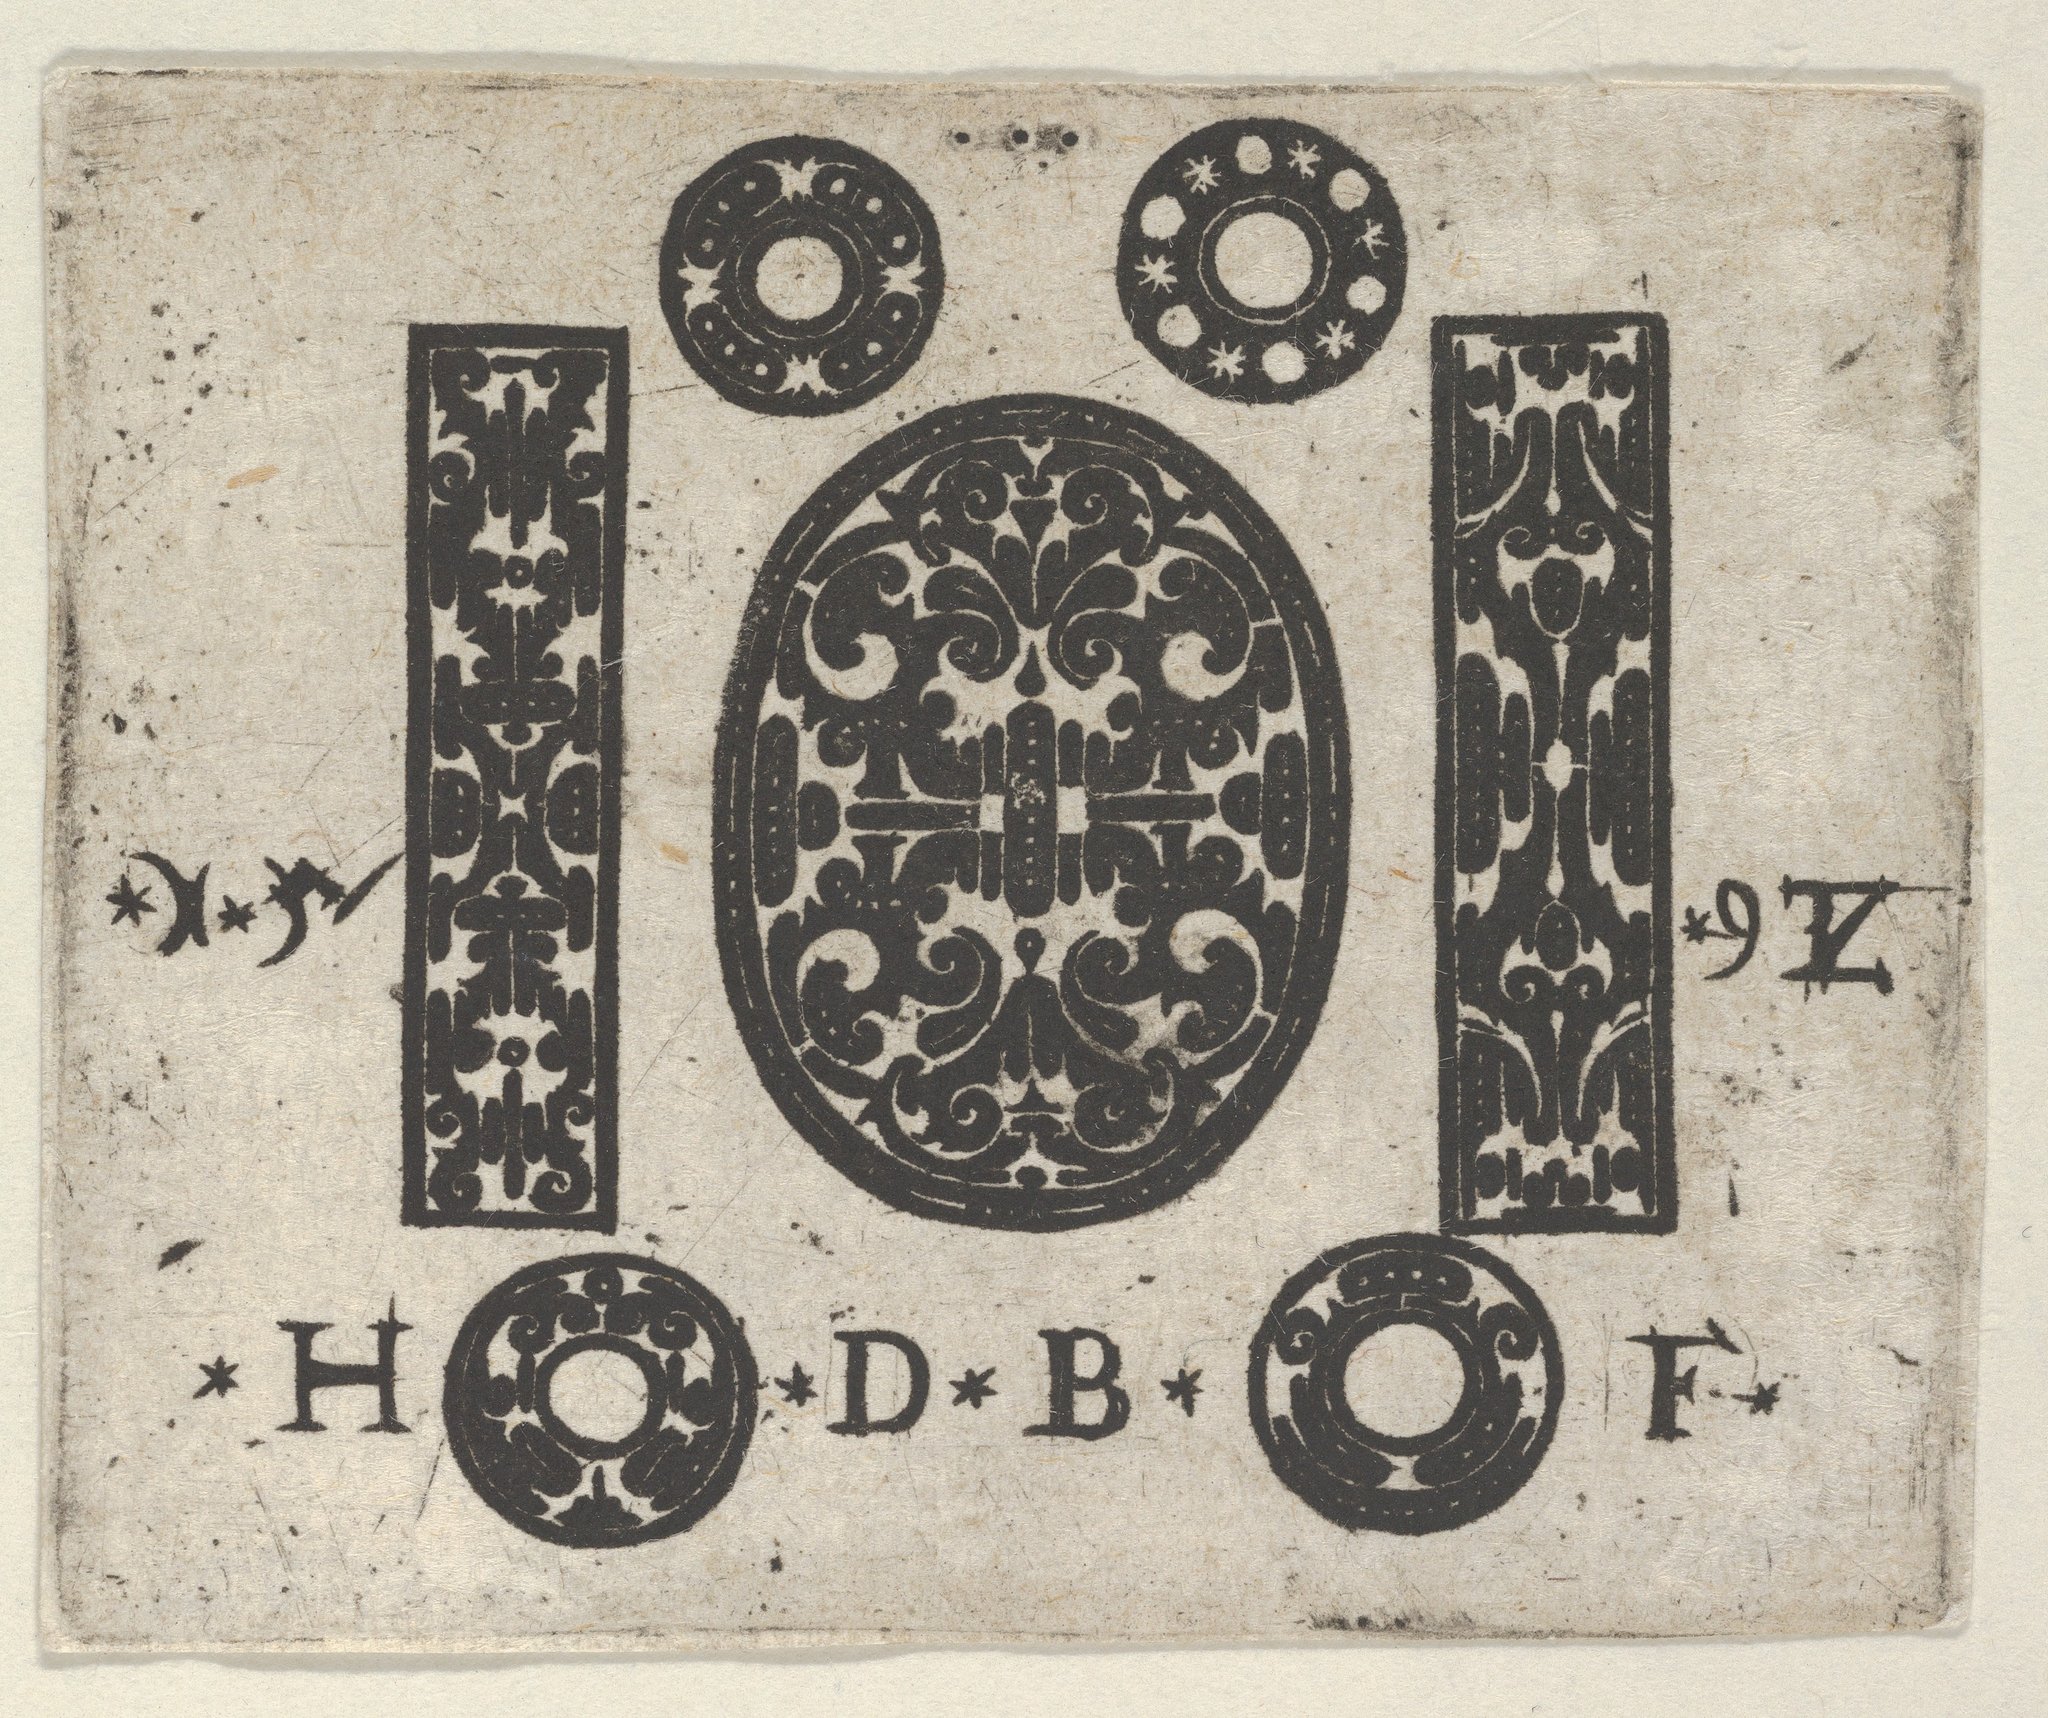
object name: print ornament architecture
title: Blackwork Print with Two Vertical Panels Flanking an Oval at Center with Four Small Circles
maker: hans de bull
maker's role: artist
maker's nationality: german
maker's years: 1592-1604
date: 1592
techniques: embroidery, engraving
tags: ornament